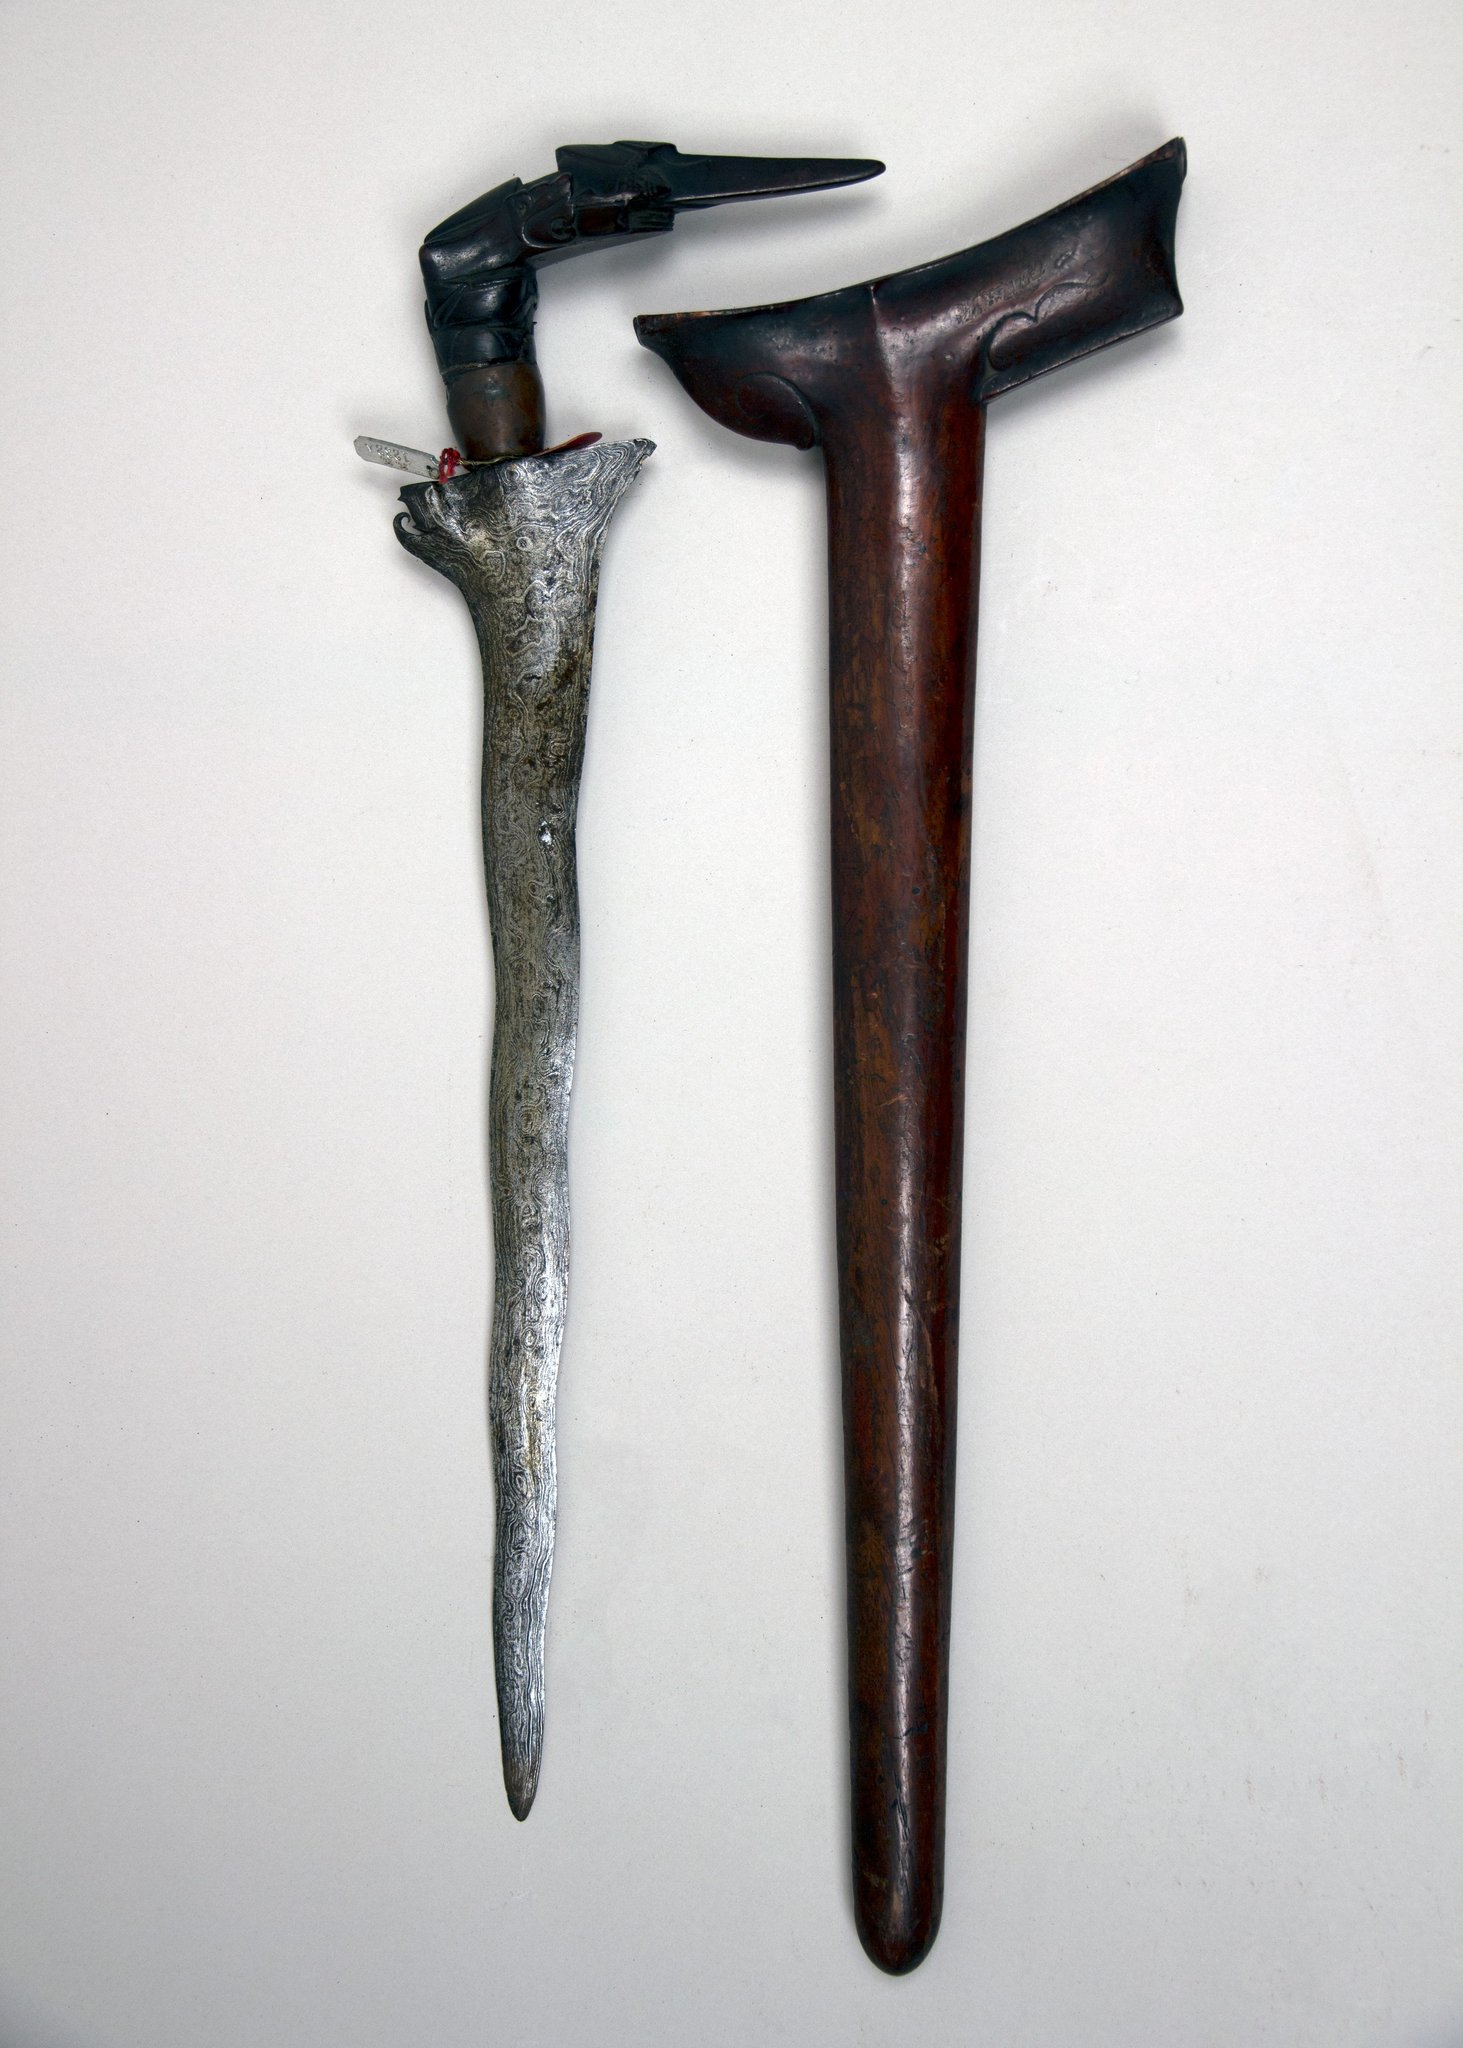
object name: kris with sheath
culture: sumatran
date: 1501-1900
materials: wood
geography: indonesia